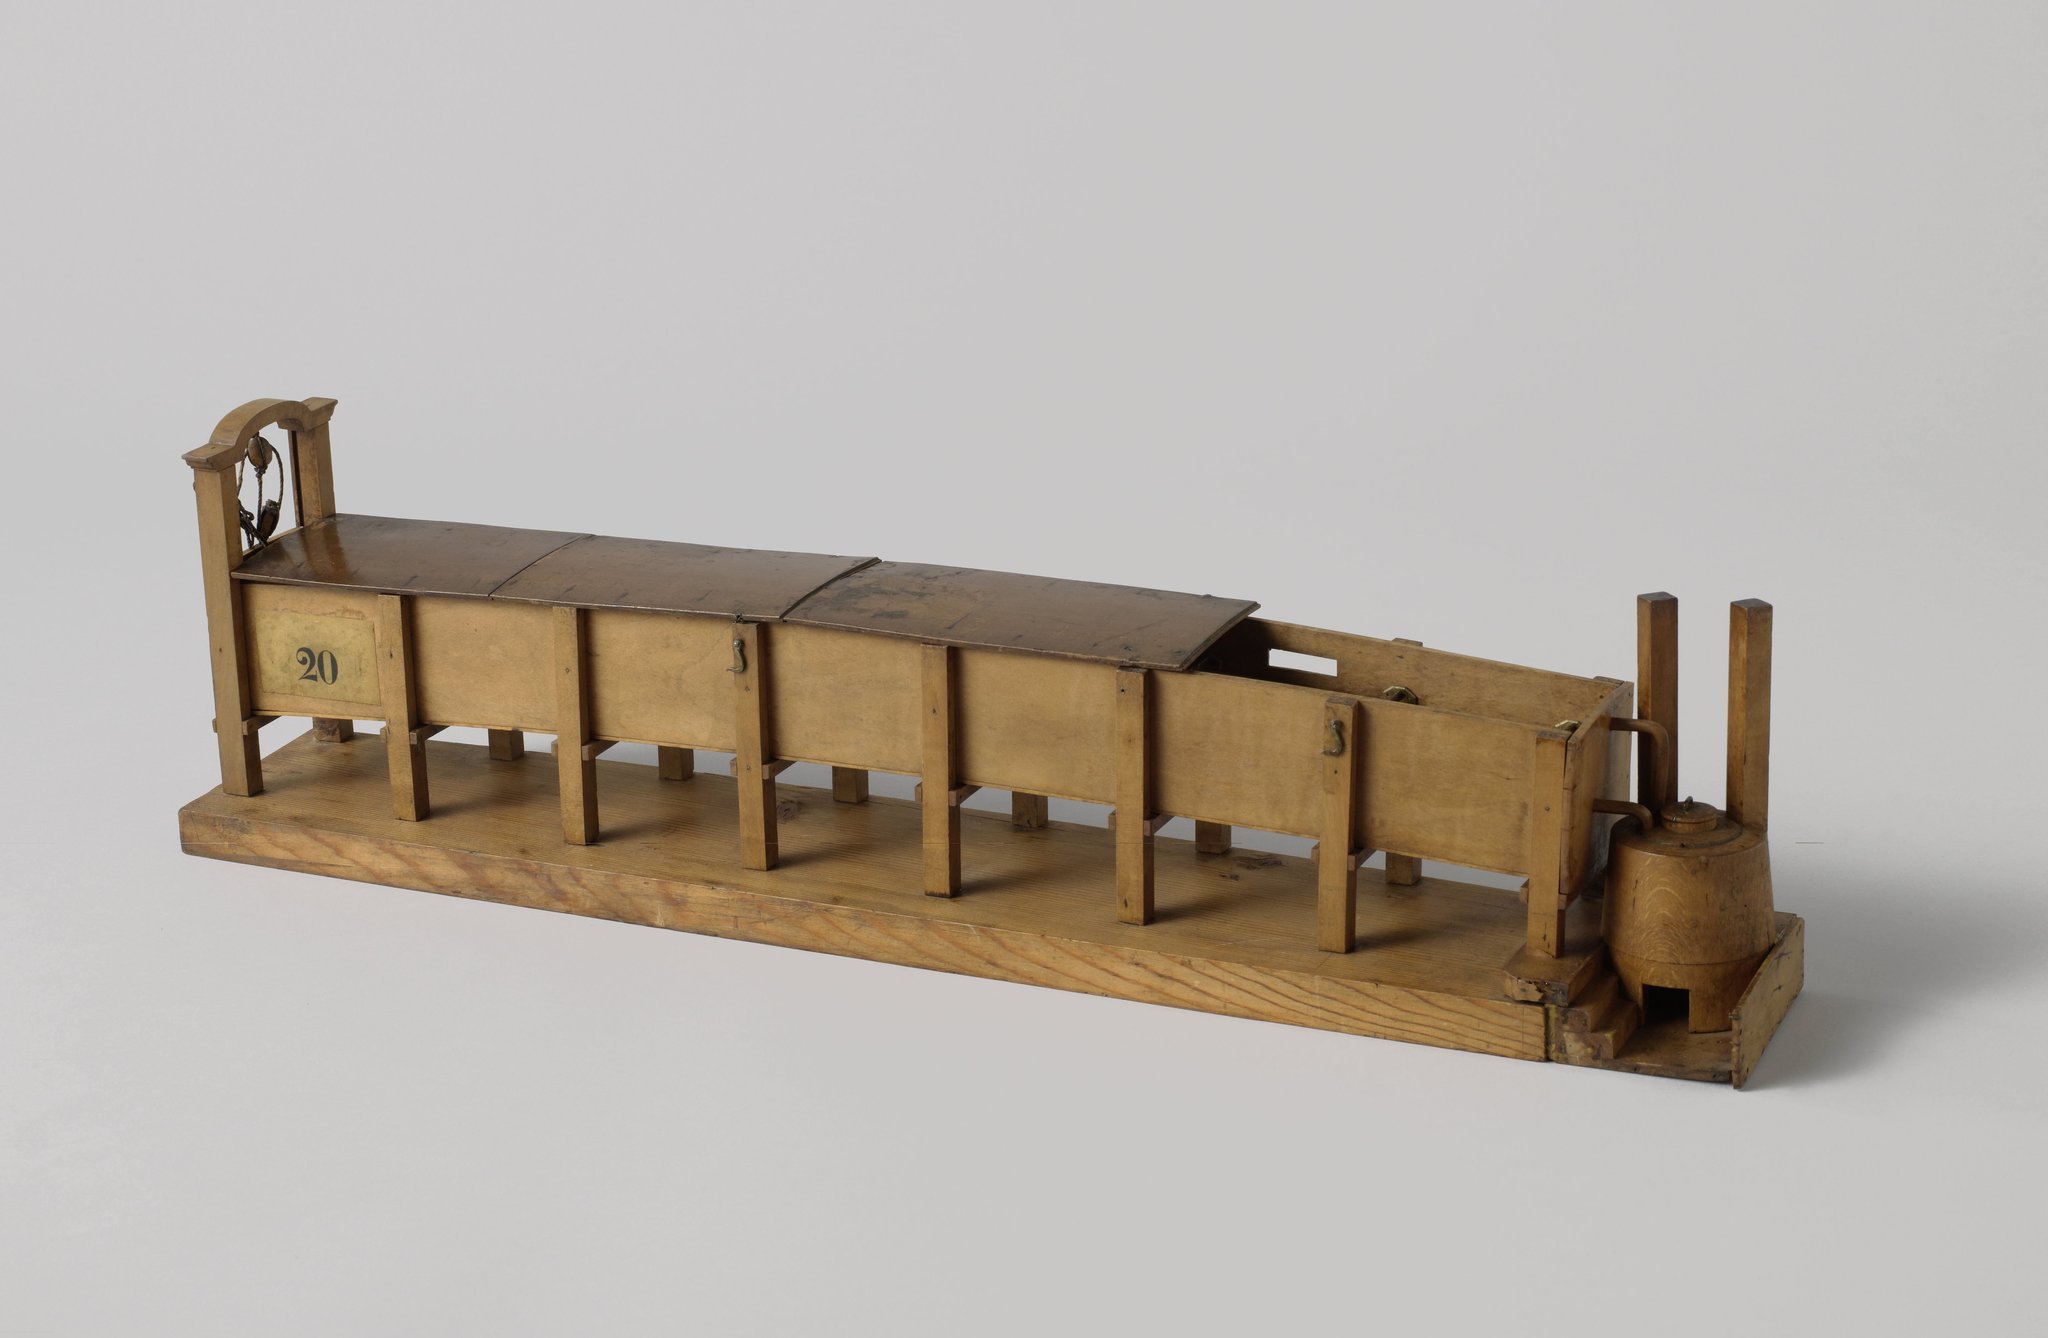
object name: demonstration model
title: Model of a Wood Kiln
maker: Anonymous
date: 1798-1807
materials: brass, iron, fiber, wood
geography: amsterdam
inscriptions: label, left: ‘20’ former inventory label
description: Model van een houtstoof of stoomkist met dubbele bodem voor het buigen van planken, op een grondplank. Het is een lange, gebogen kist waarin twee niveaus zijn aangebracht. Eén van de lange kanten, waarin kleine deurtjes zijn aangebracht, is bol gebogen. Op de vloeren van zowel het onderste als het bovenste compartiment zijn ijzeren leggers aangebracht. De kist heeft aan een korte kant een schuifdeur met een takel voor het bovenste compartiment, de deur voor het onderste compartiment ontbreekt. Aan de andere kant staat een ketel met leidingen naar de twee compartimenten; onder de ketel, onder grondniveau, is een ovendeur.